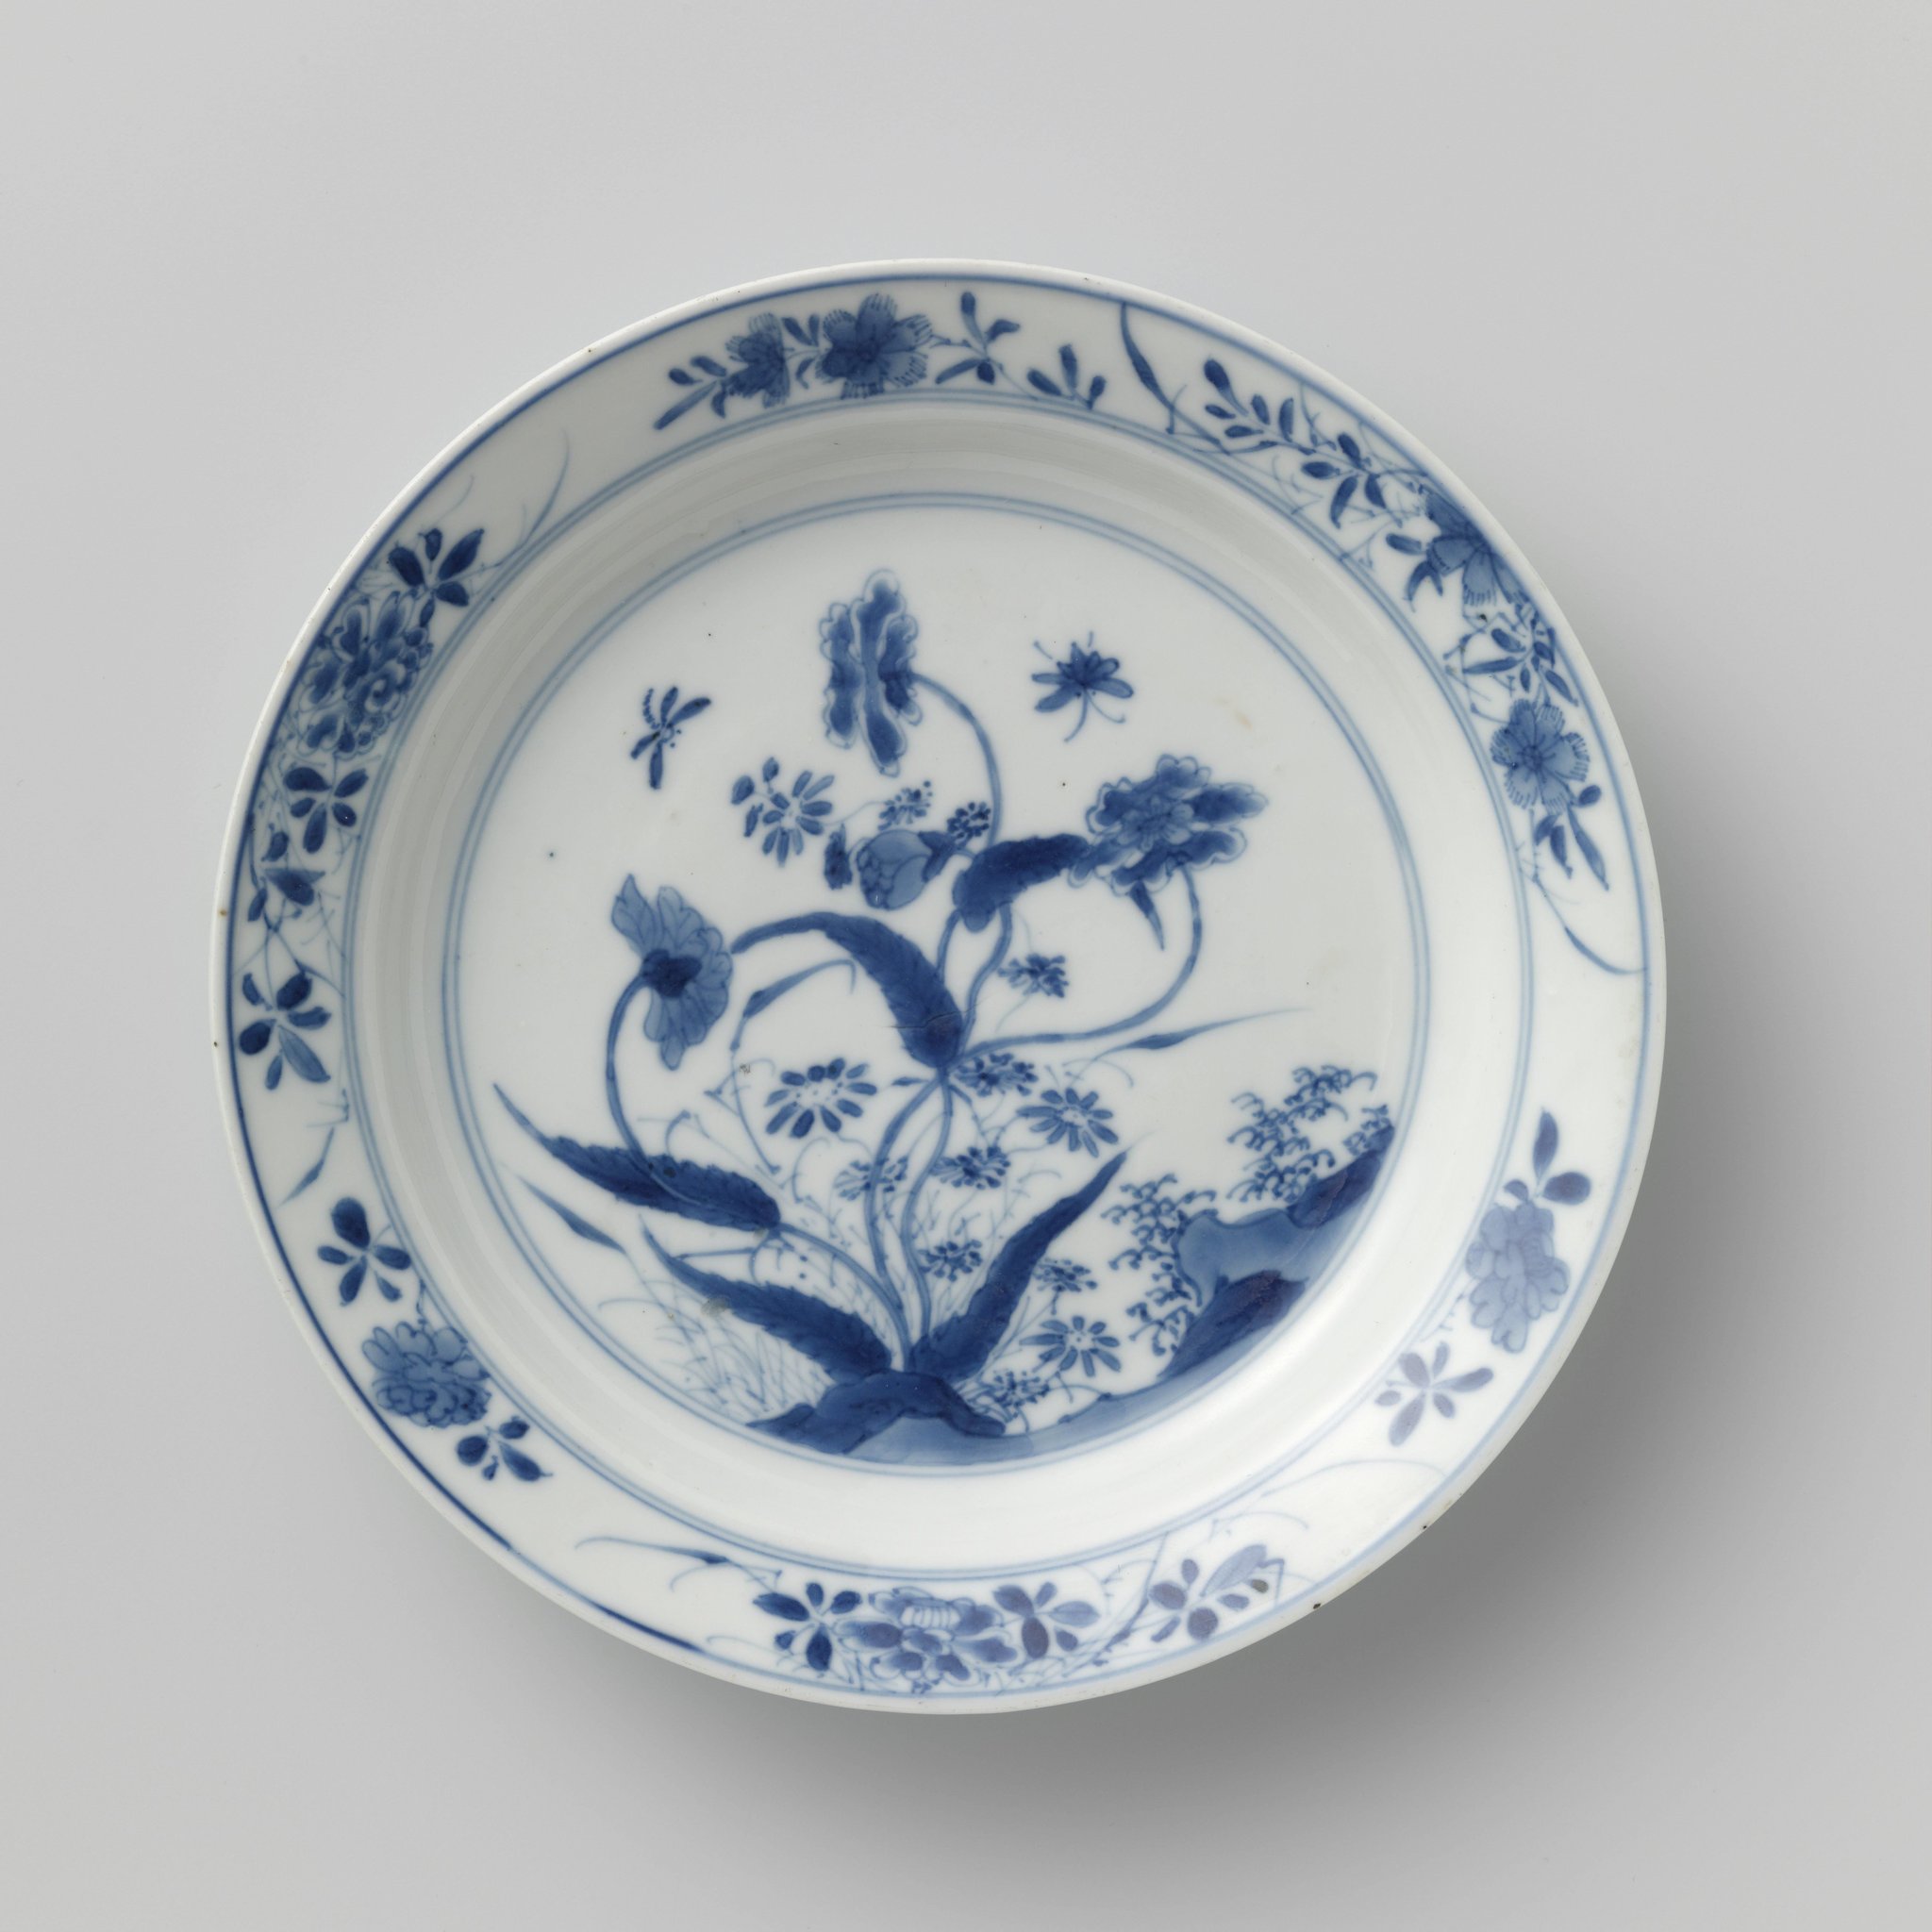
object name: plate dish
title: Plate with rocks, flower sprays and butterflies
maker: Anonymous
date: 1700-1724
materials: cobalt, glaze, paint, porcelain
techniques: firing, turning, vitrification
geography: china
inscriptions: mark: ‘大 明 成 化 年 製’